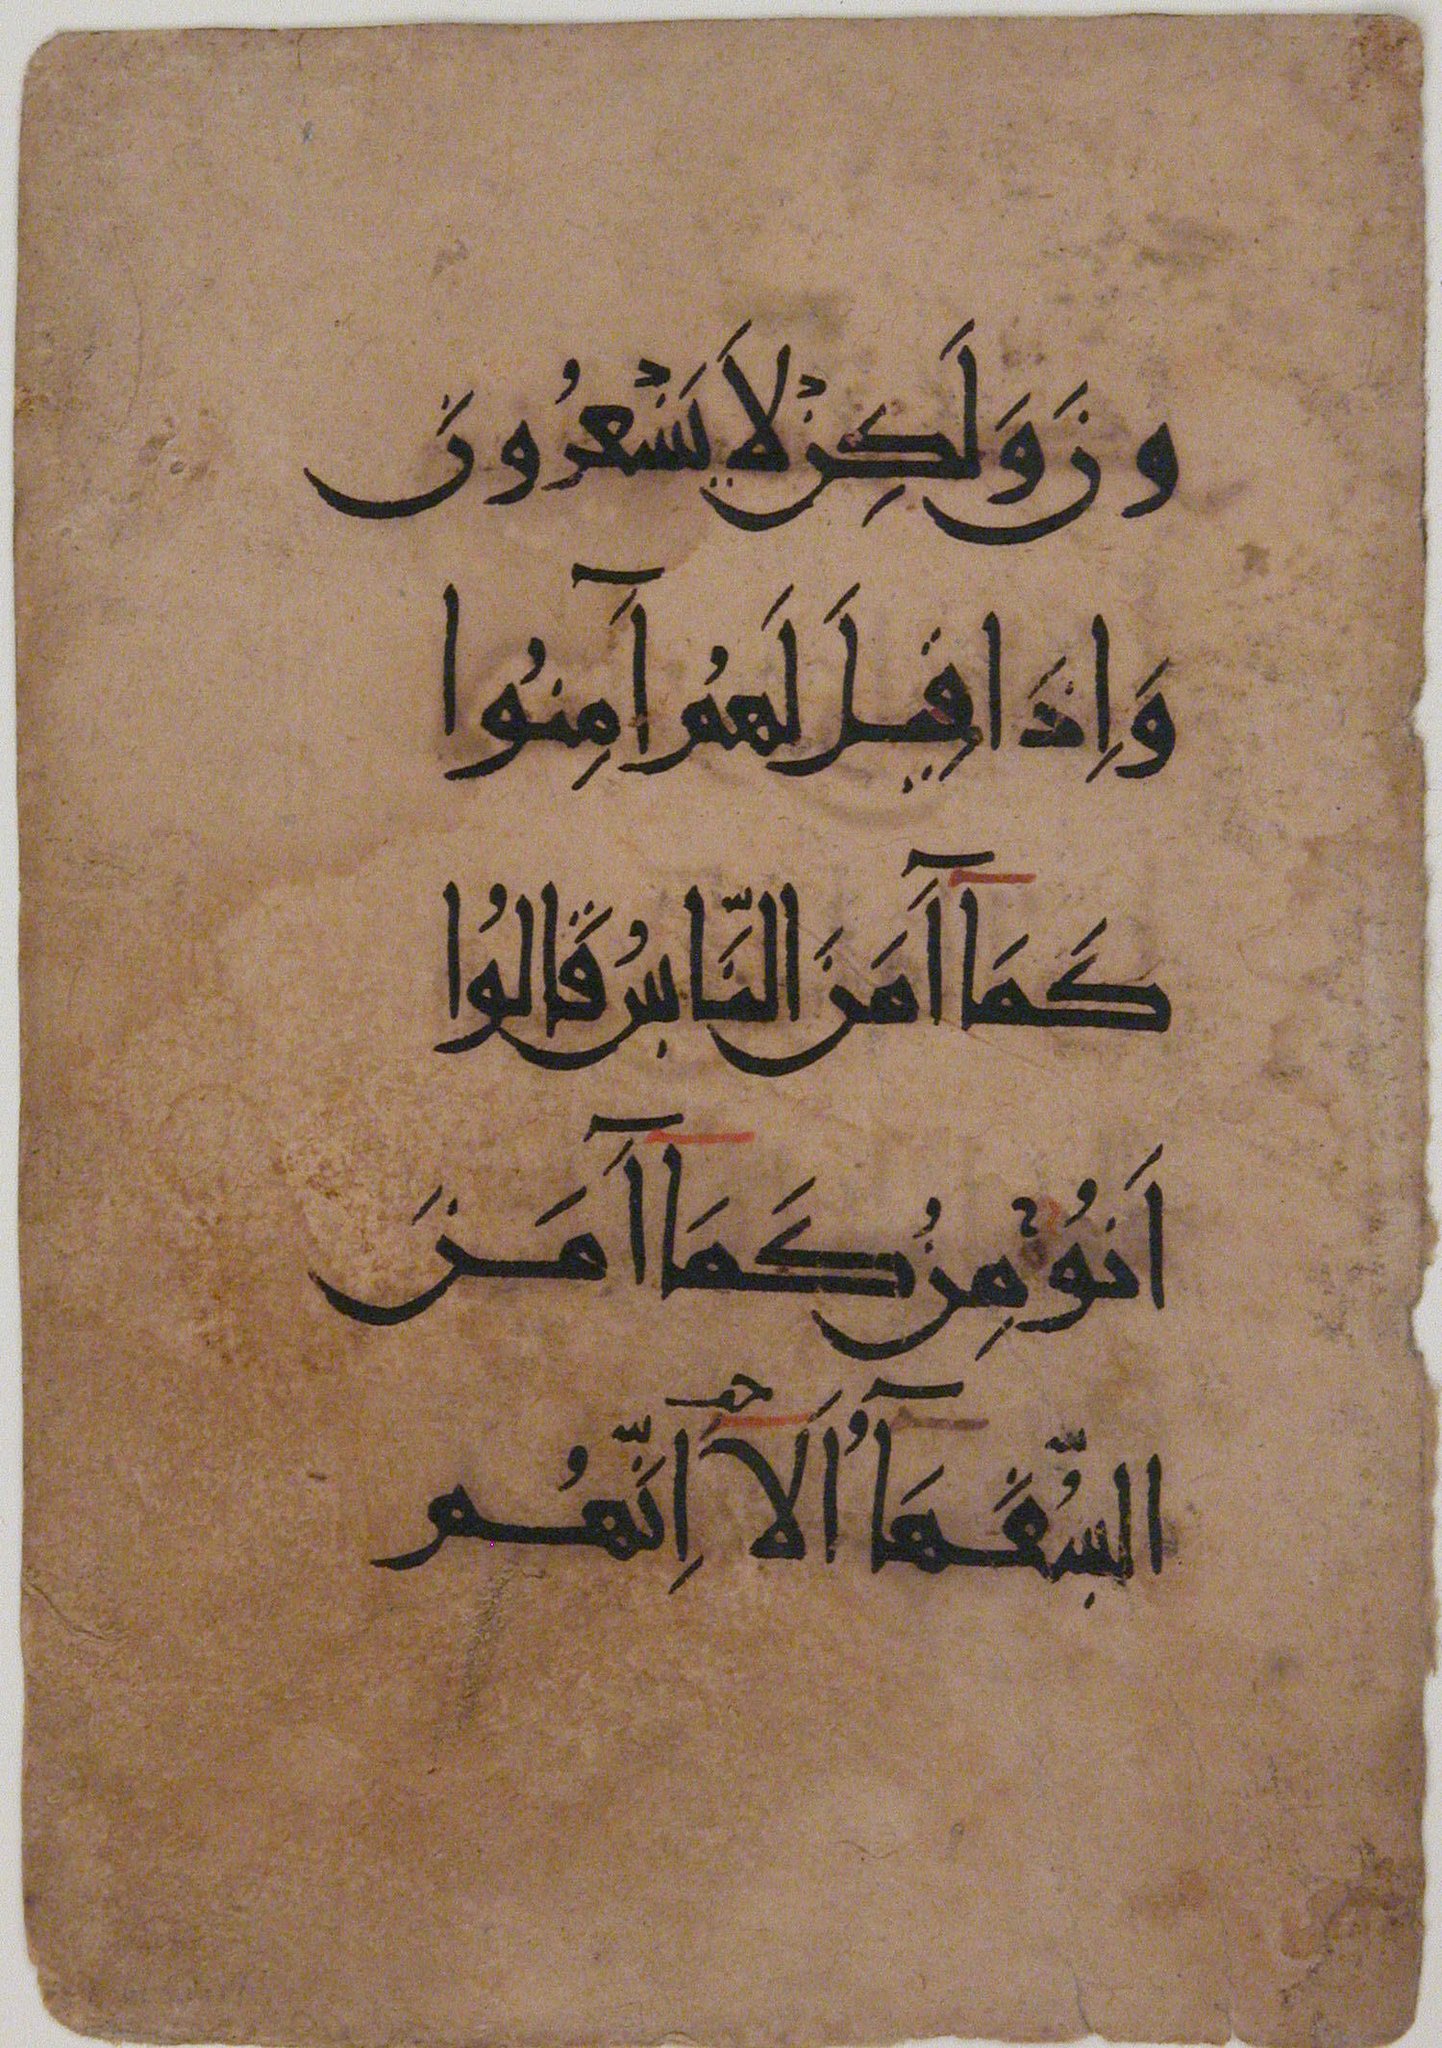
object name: folio from a non illustrated manuscript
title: Folio from a Qur'an Manuscript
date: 1001-1200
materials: ink, paper, watercolor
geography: egypt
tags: qur'an